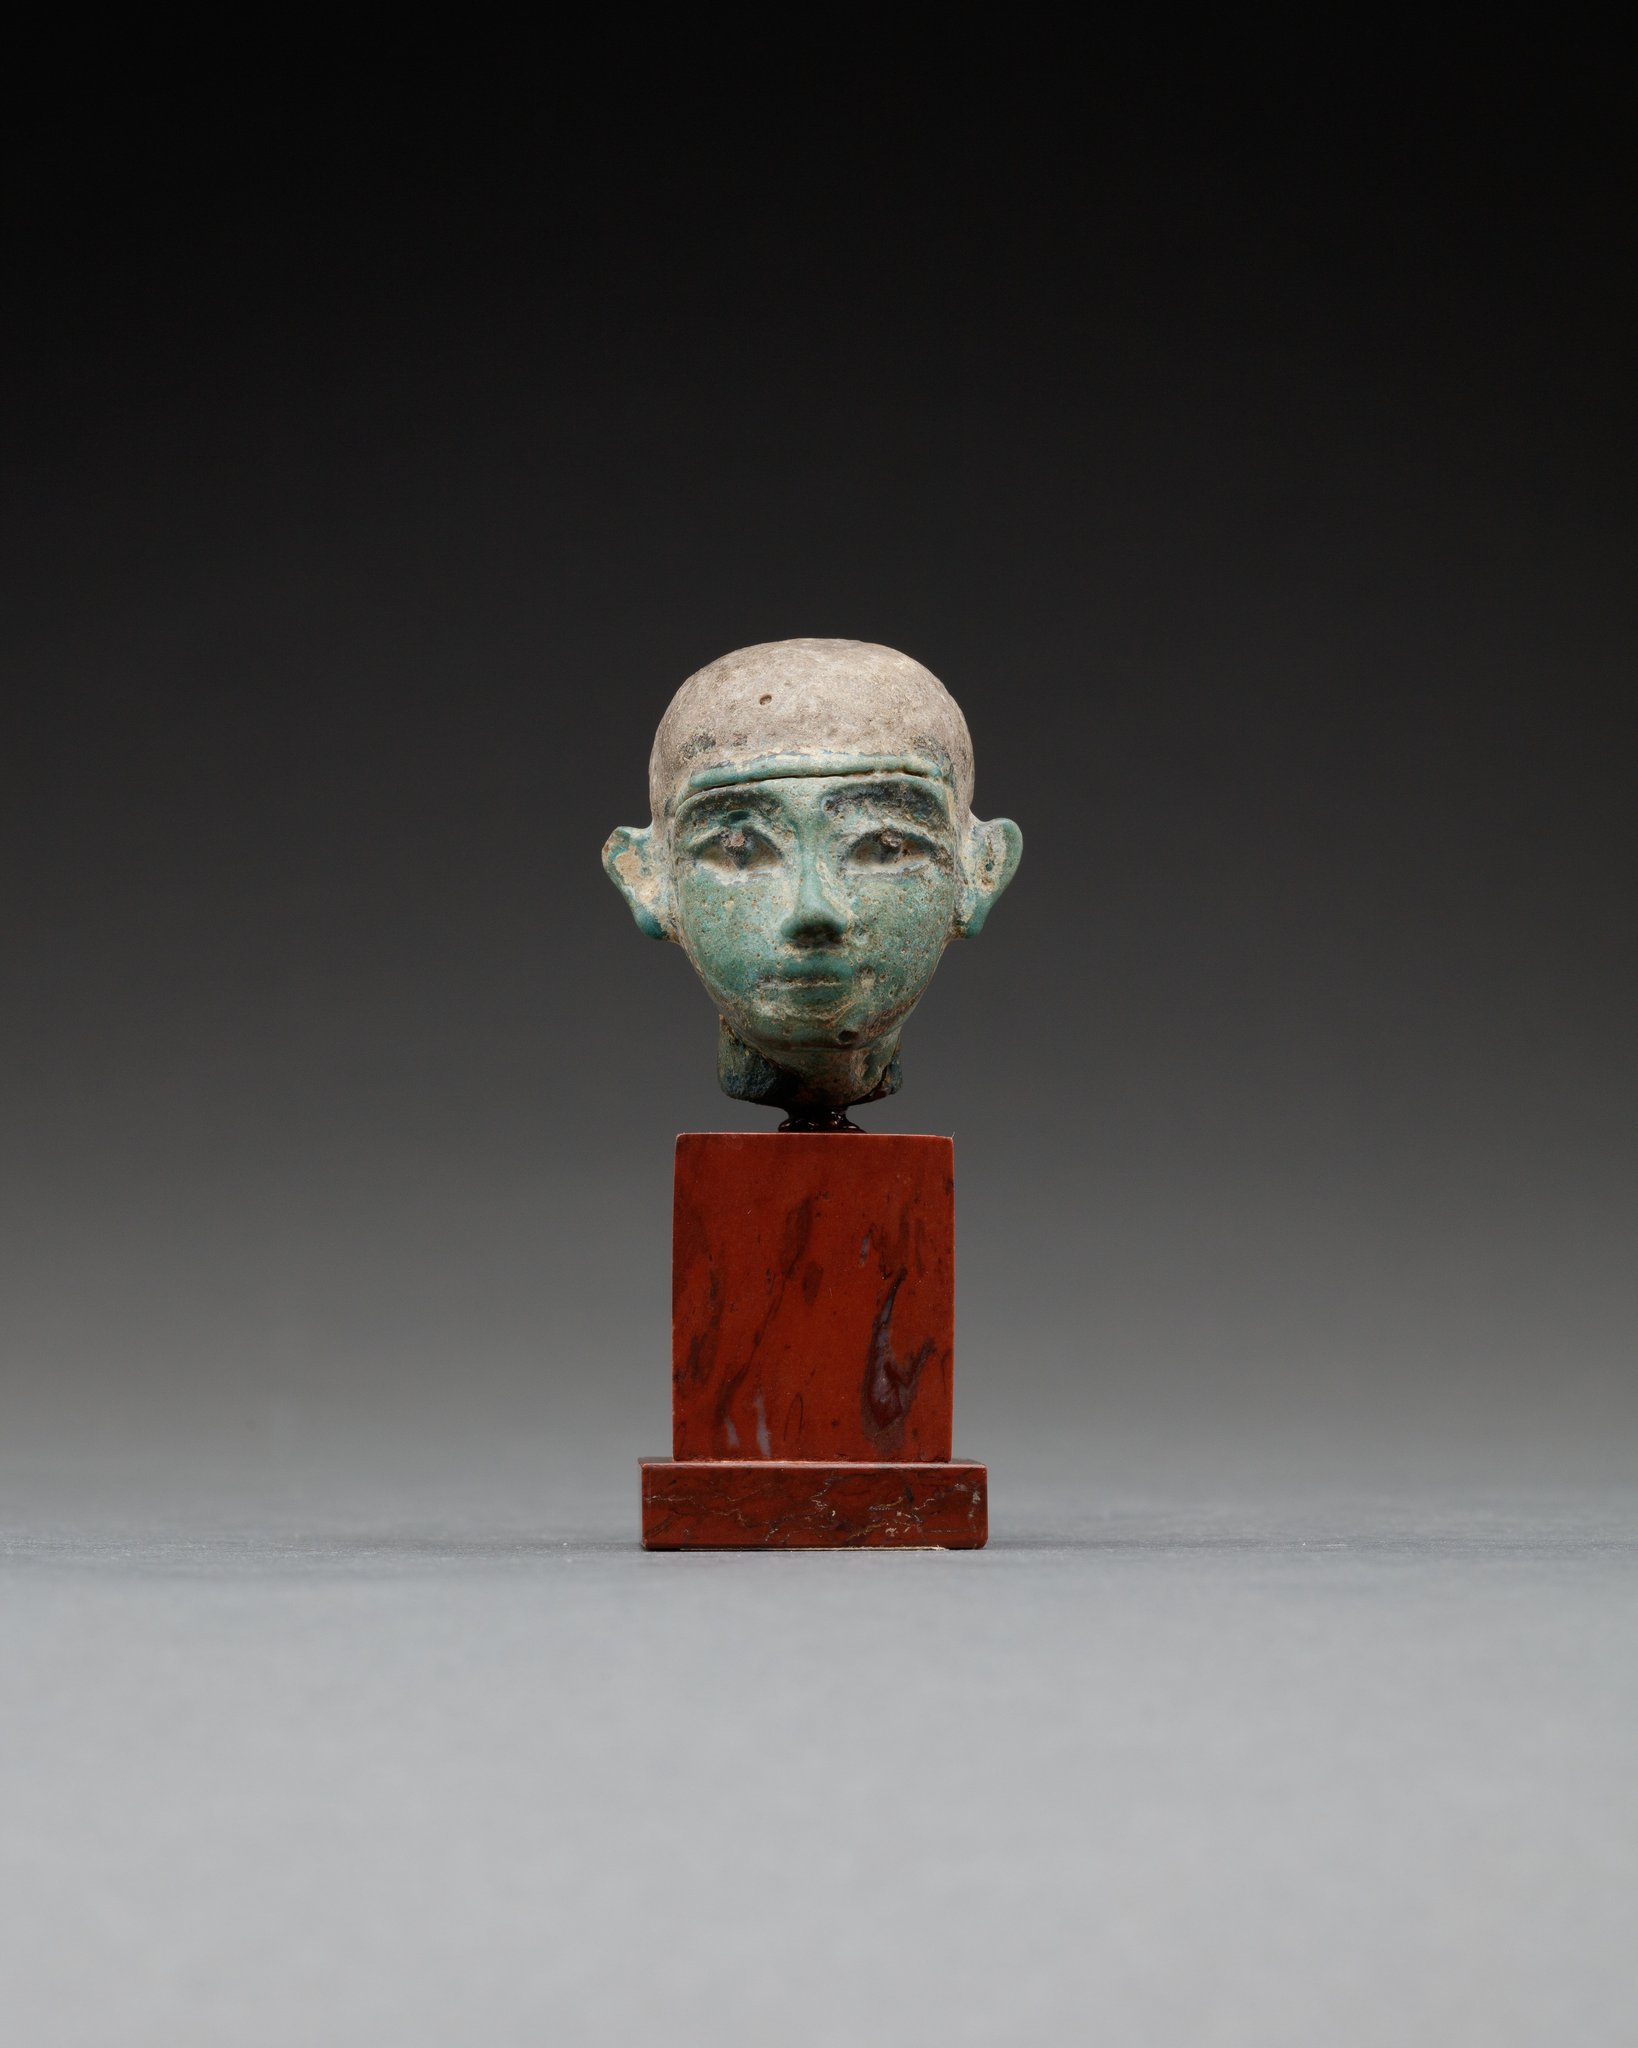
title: Head of Ptah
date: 1550-1000 BCE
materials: faience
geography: egypt